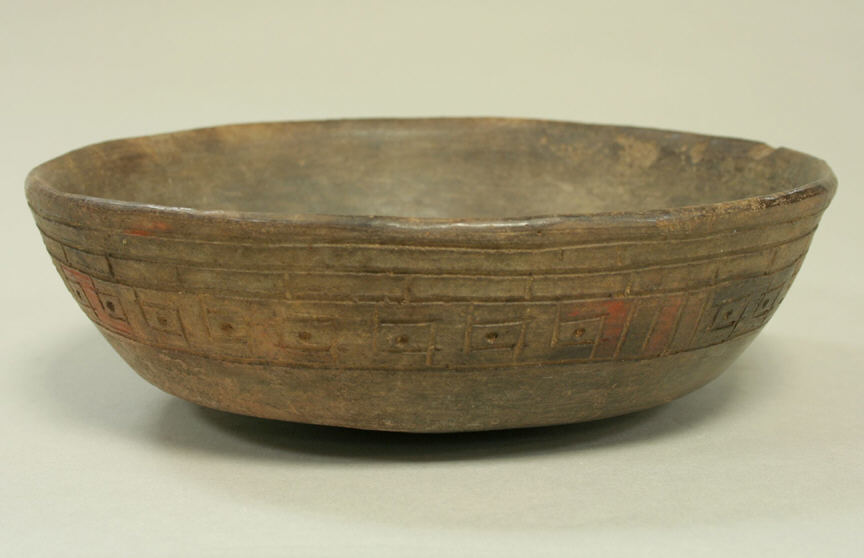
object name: bowl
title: Incised Painted Bowl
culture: paracas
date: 500-101 BCE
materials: ceramic, pigment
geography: peru